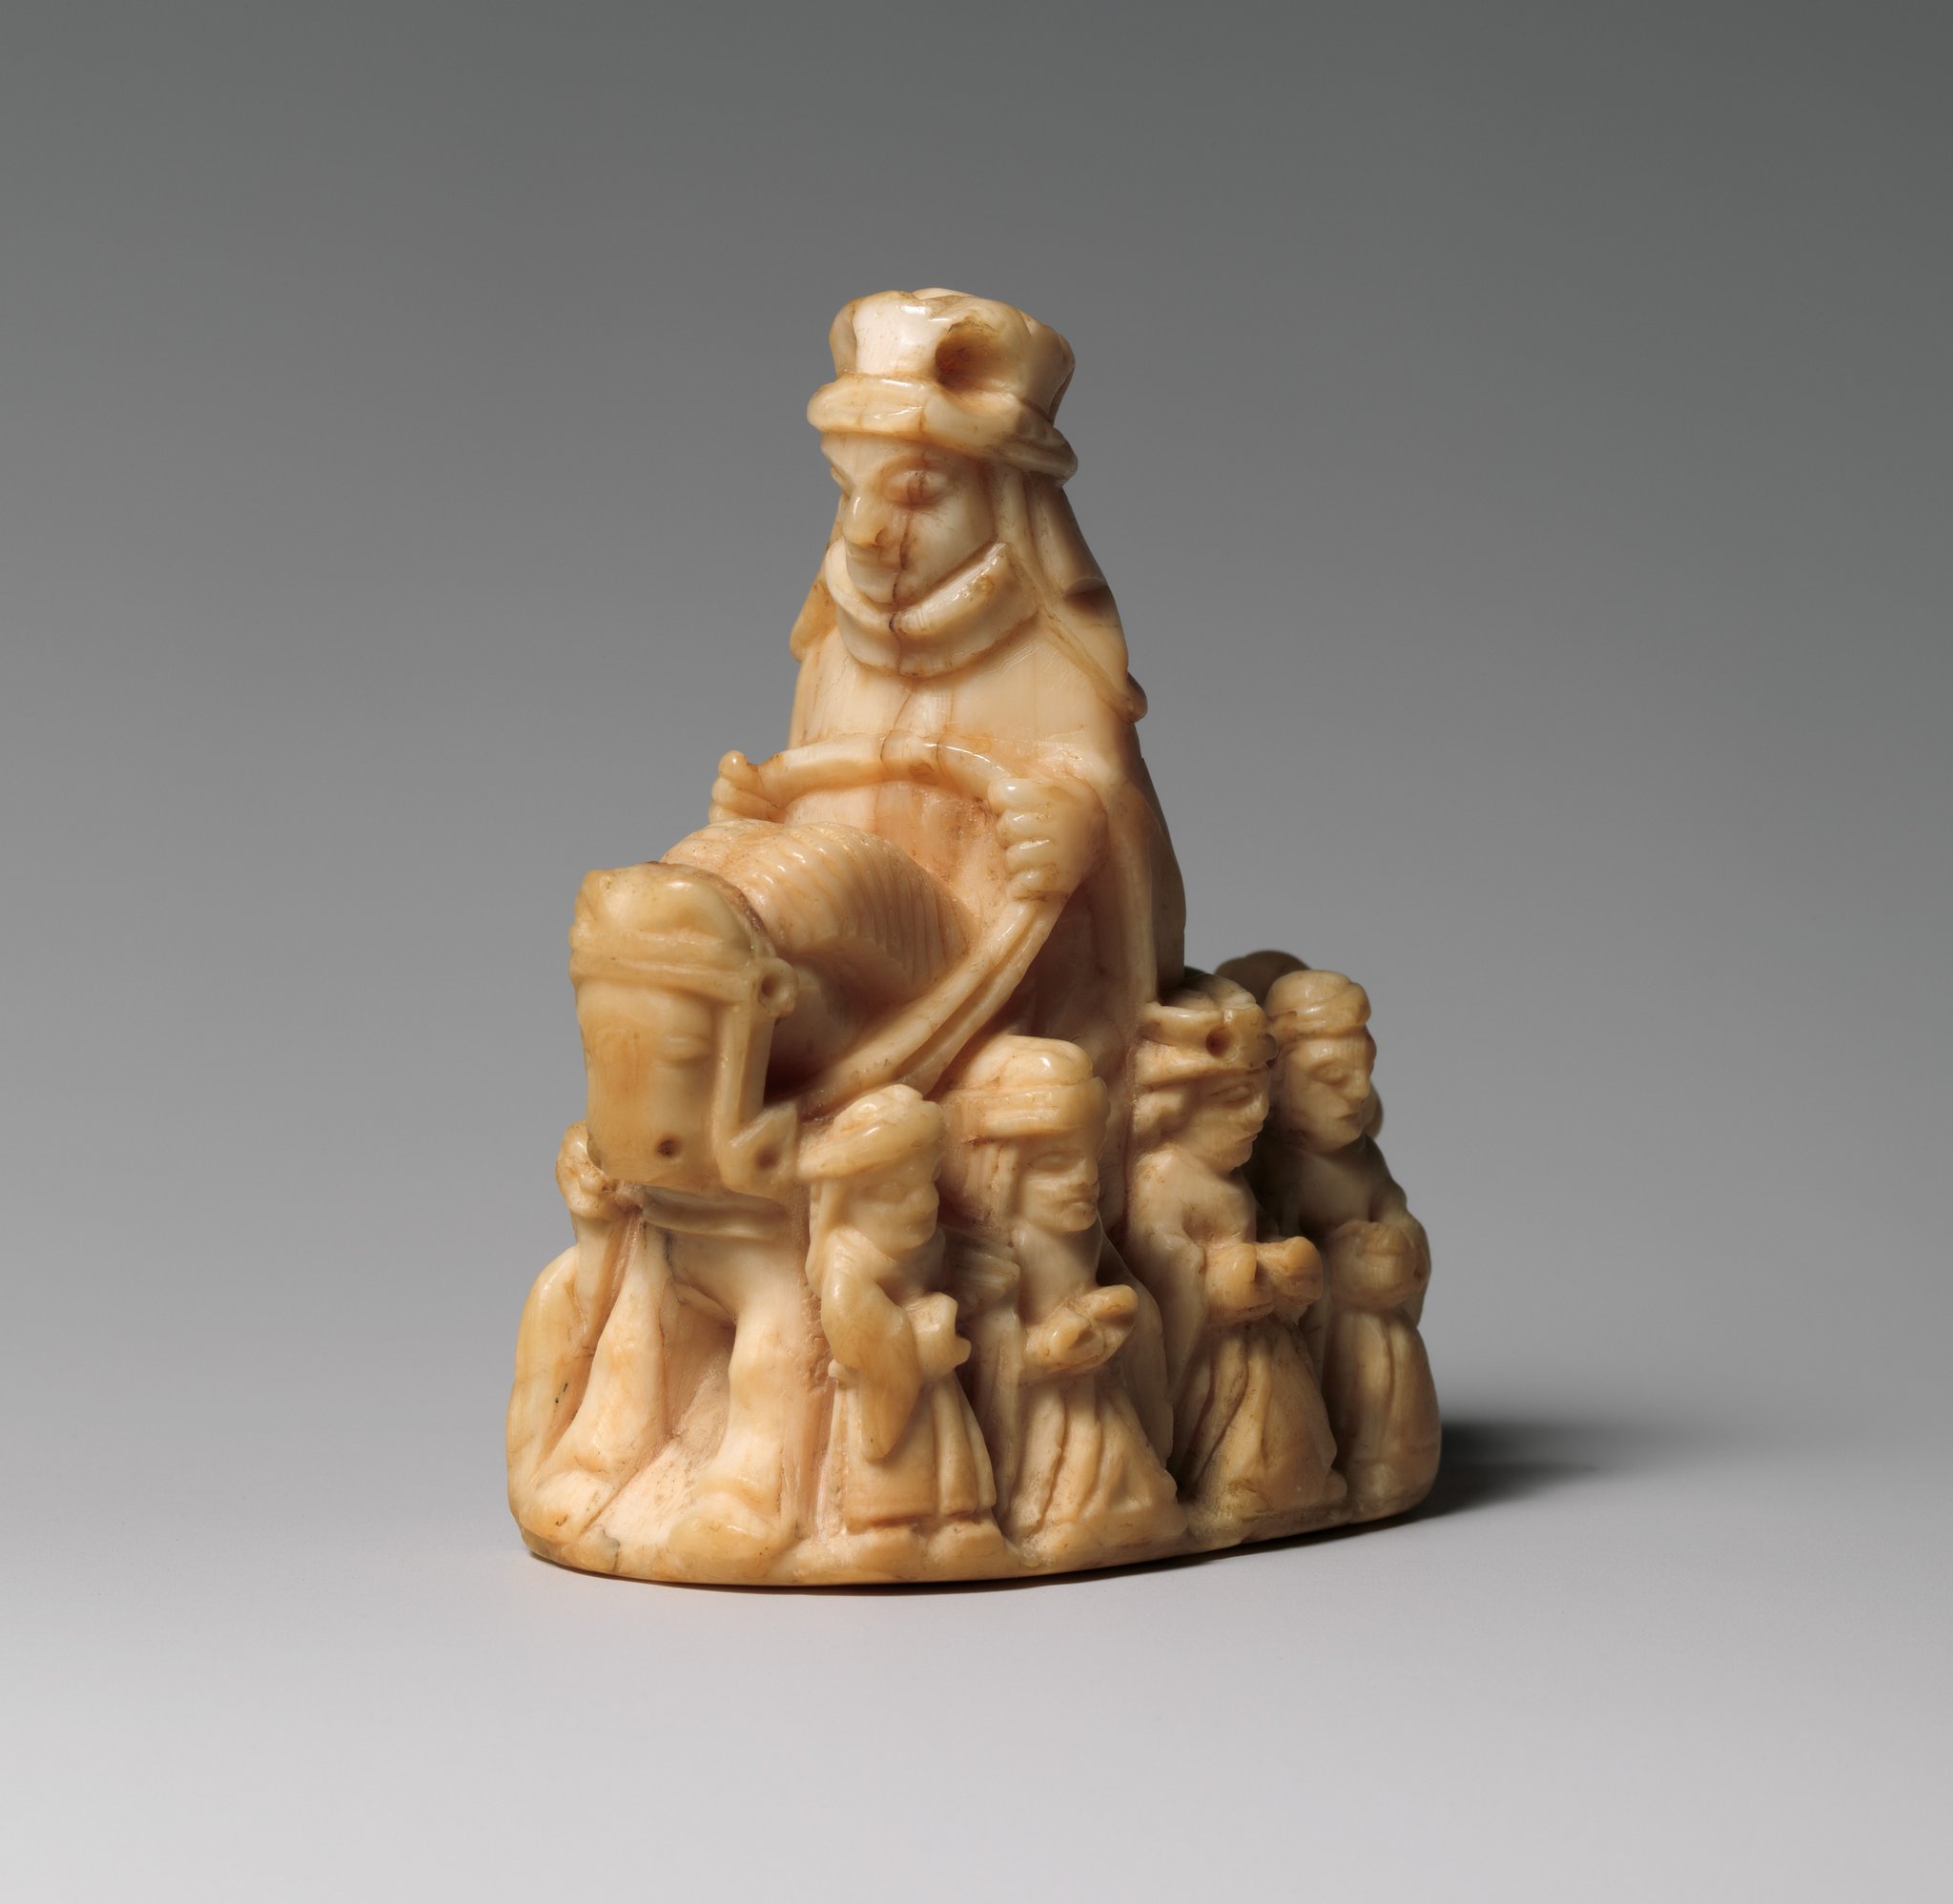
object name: chess piece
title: Queen Chess Piece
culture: scandinavian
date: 1201-1300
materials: ivory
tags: chess